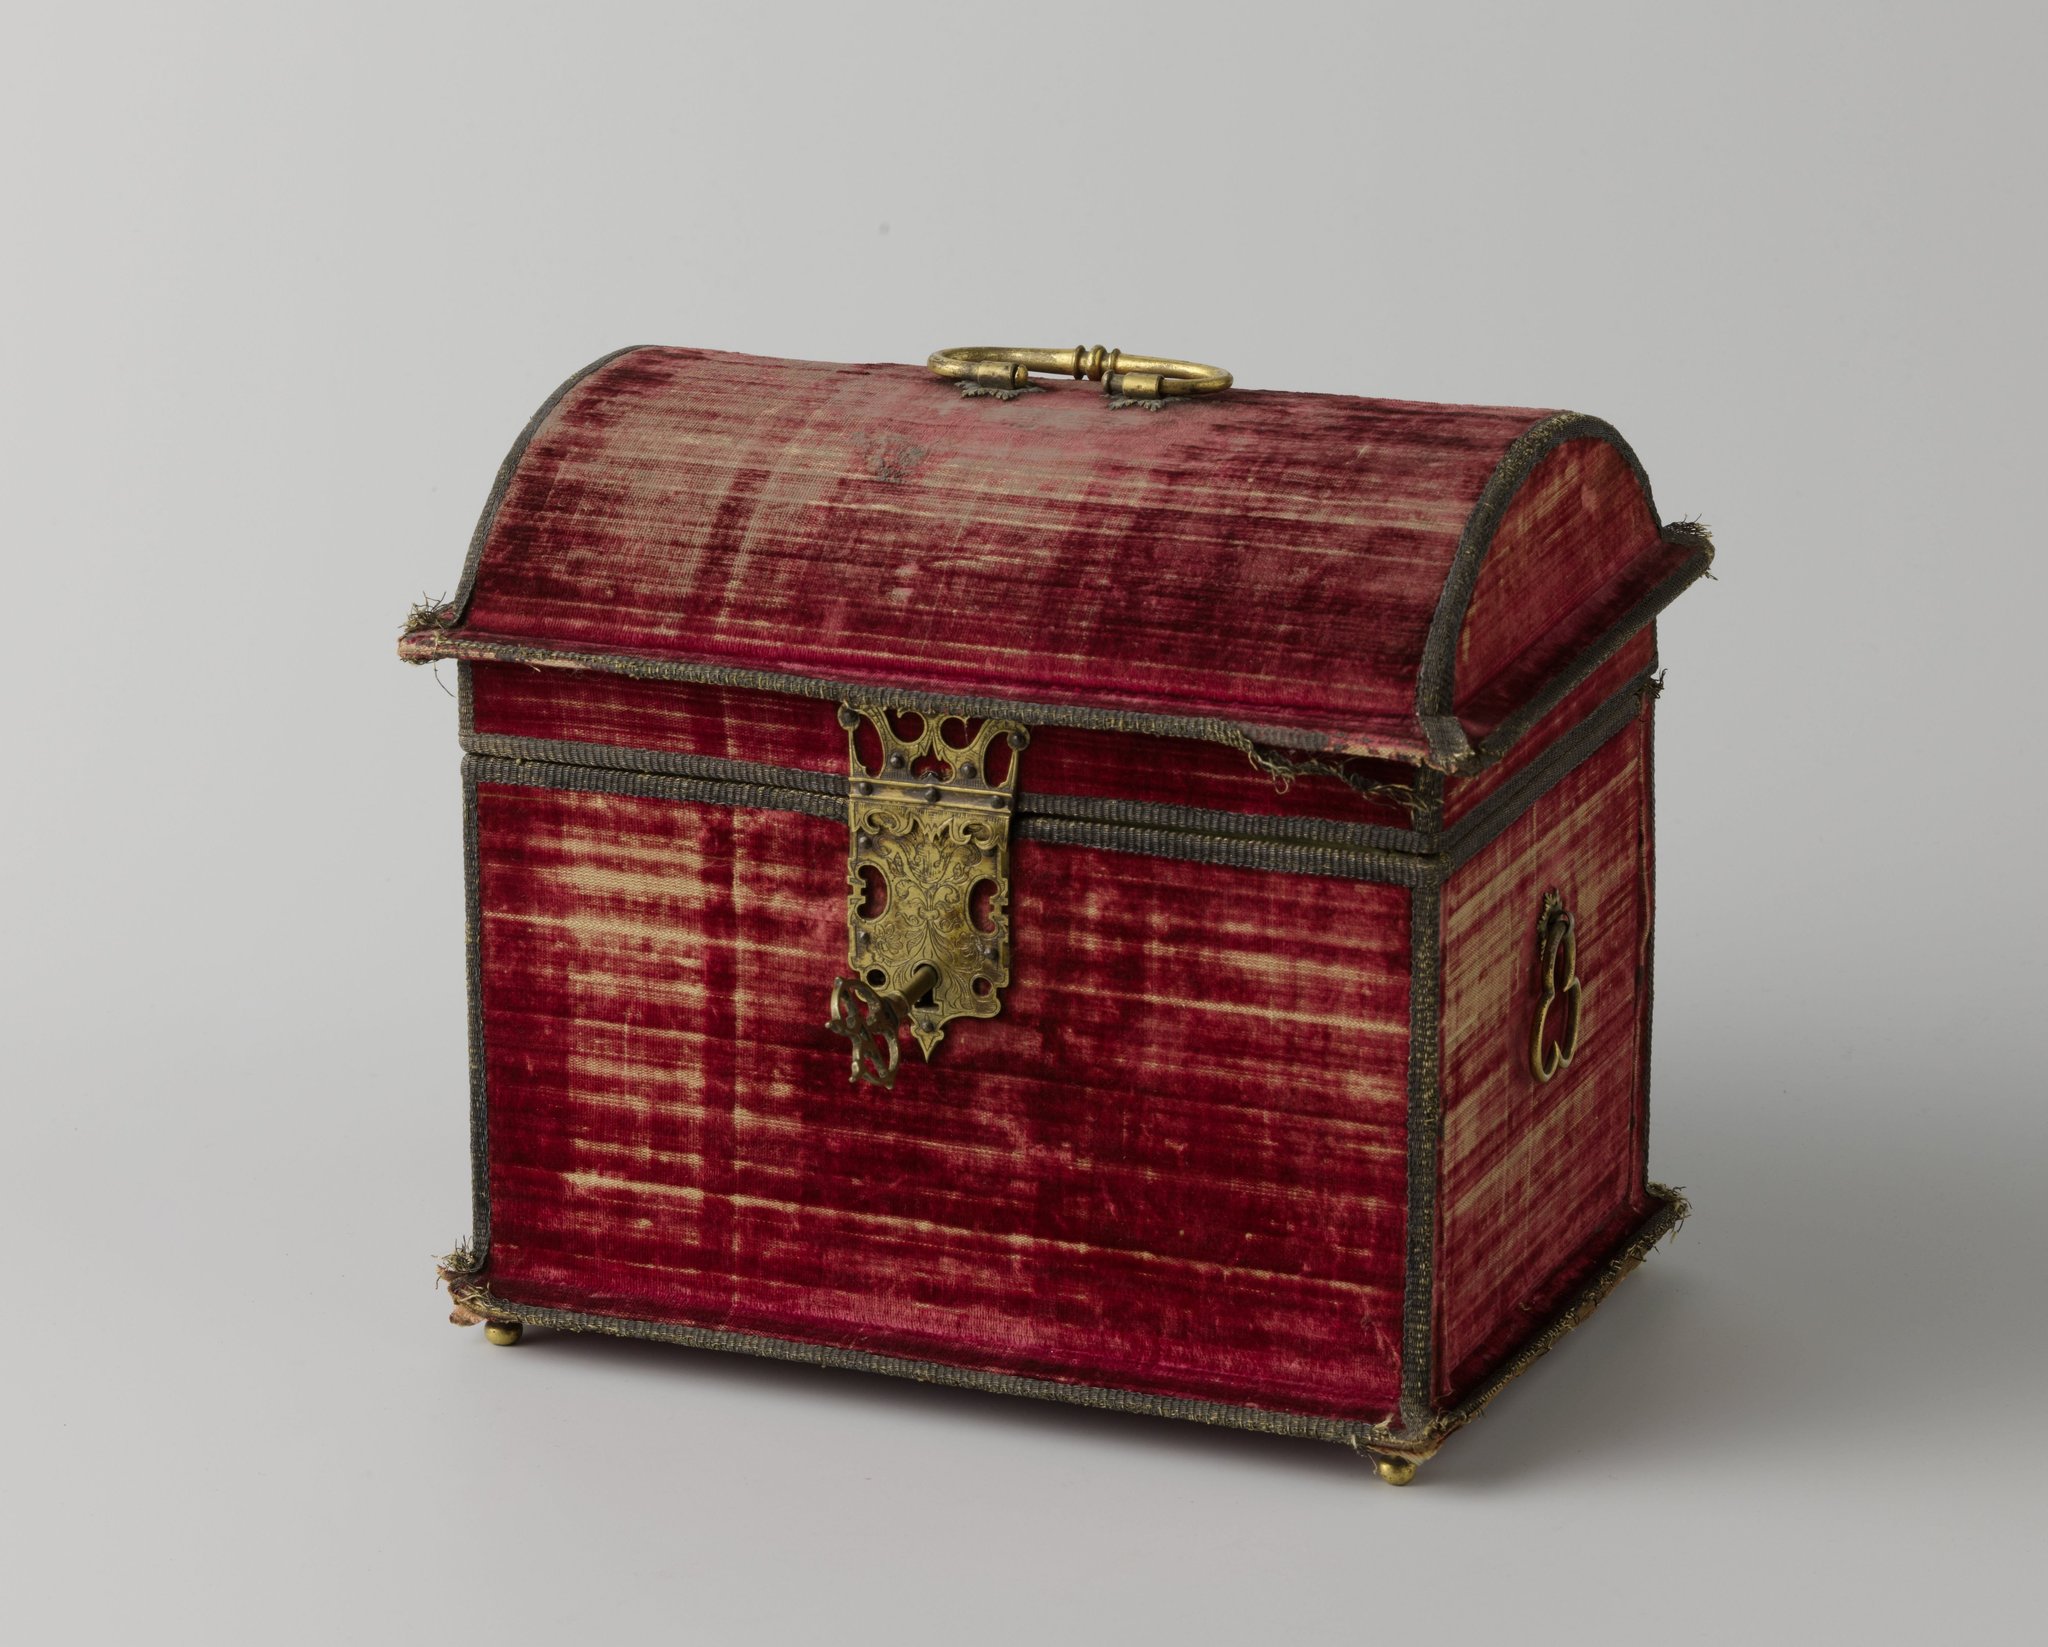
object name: chest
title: Bijouteriekist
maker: Anonymous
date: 1580-1600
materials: copper, textile, wood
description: Bijouteriekist, bekleed met rood fluweel en gemonteerd met koperen montuur. Rond gebogen deksel. Met sleutel van koper.